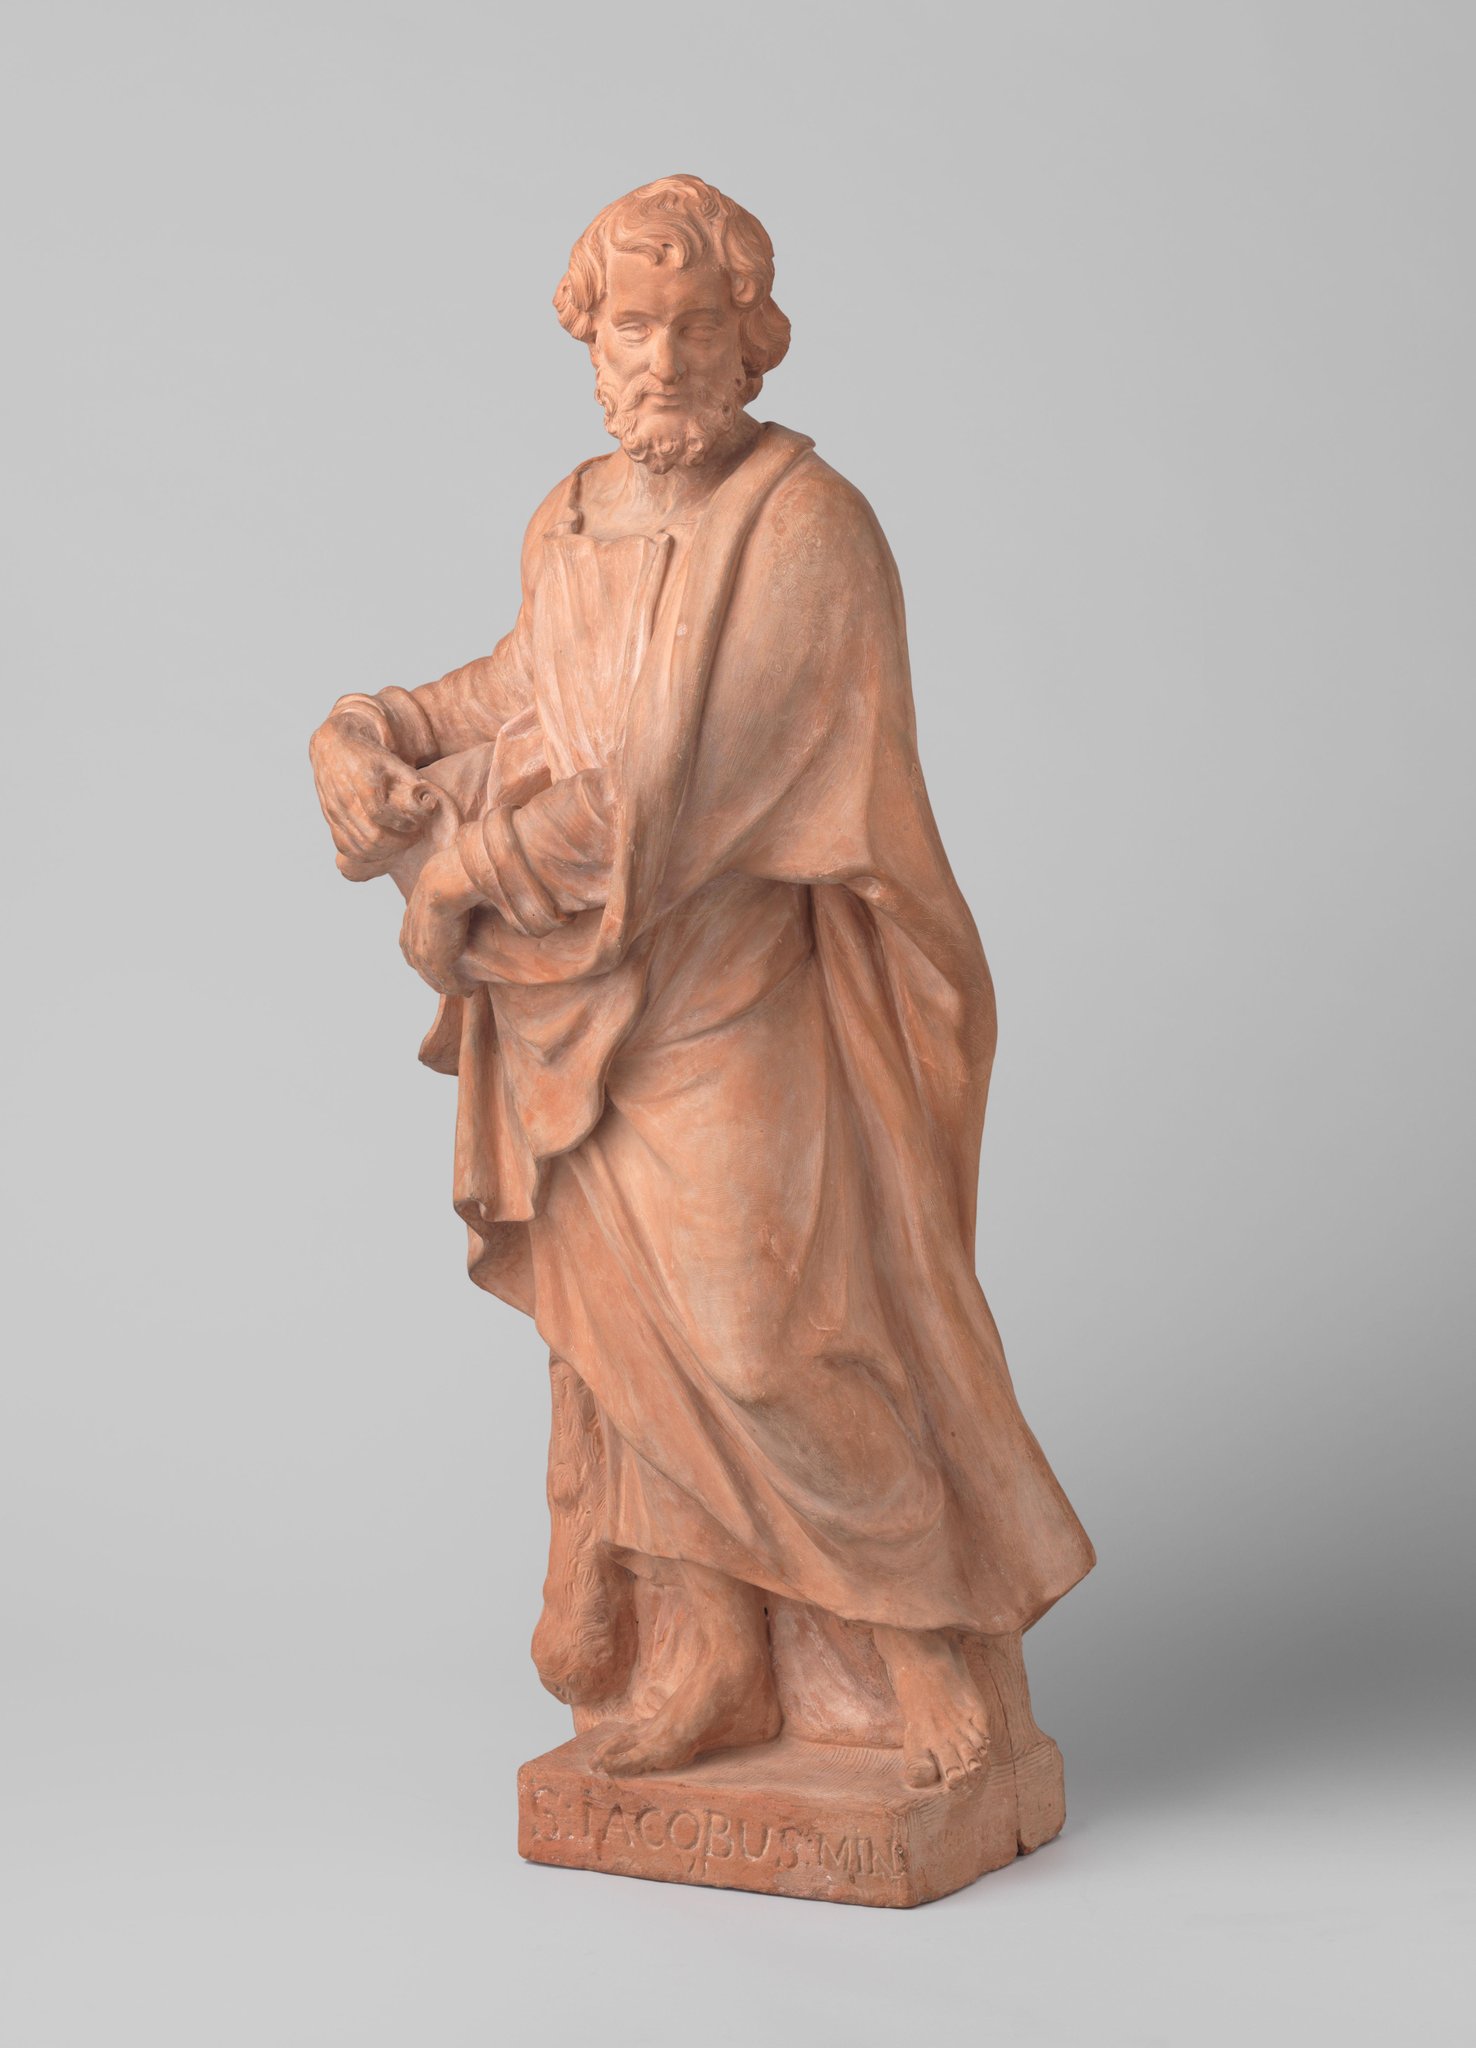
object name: sculpture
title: St James the Less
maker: walter pompe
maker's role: draughtsman, sculptor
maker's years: 1703-1777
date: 1773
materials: terracotta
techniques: modeling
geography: antwerp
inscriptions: signature, on the right side of the plinth, incised in the wet clay: ‘W. POMPE. fec.’, inscription, on the front side of the plinth, incised in the wet clay: ‘S.IACOBUS: MIN: / VI’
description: Walter Pompe (1703 - 1777) St James Minor. Terracotta. Antwerp, 1773.